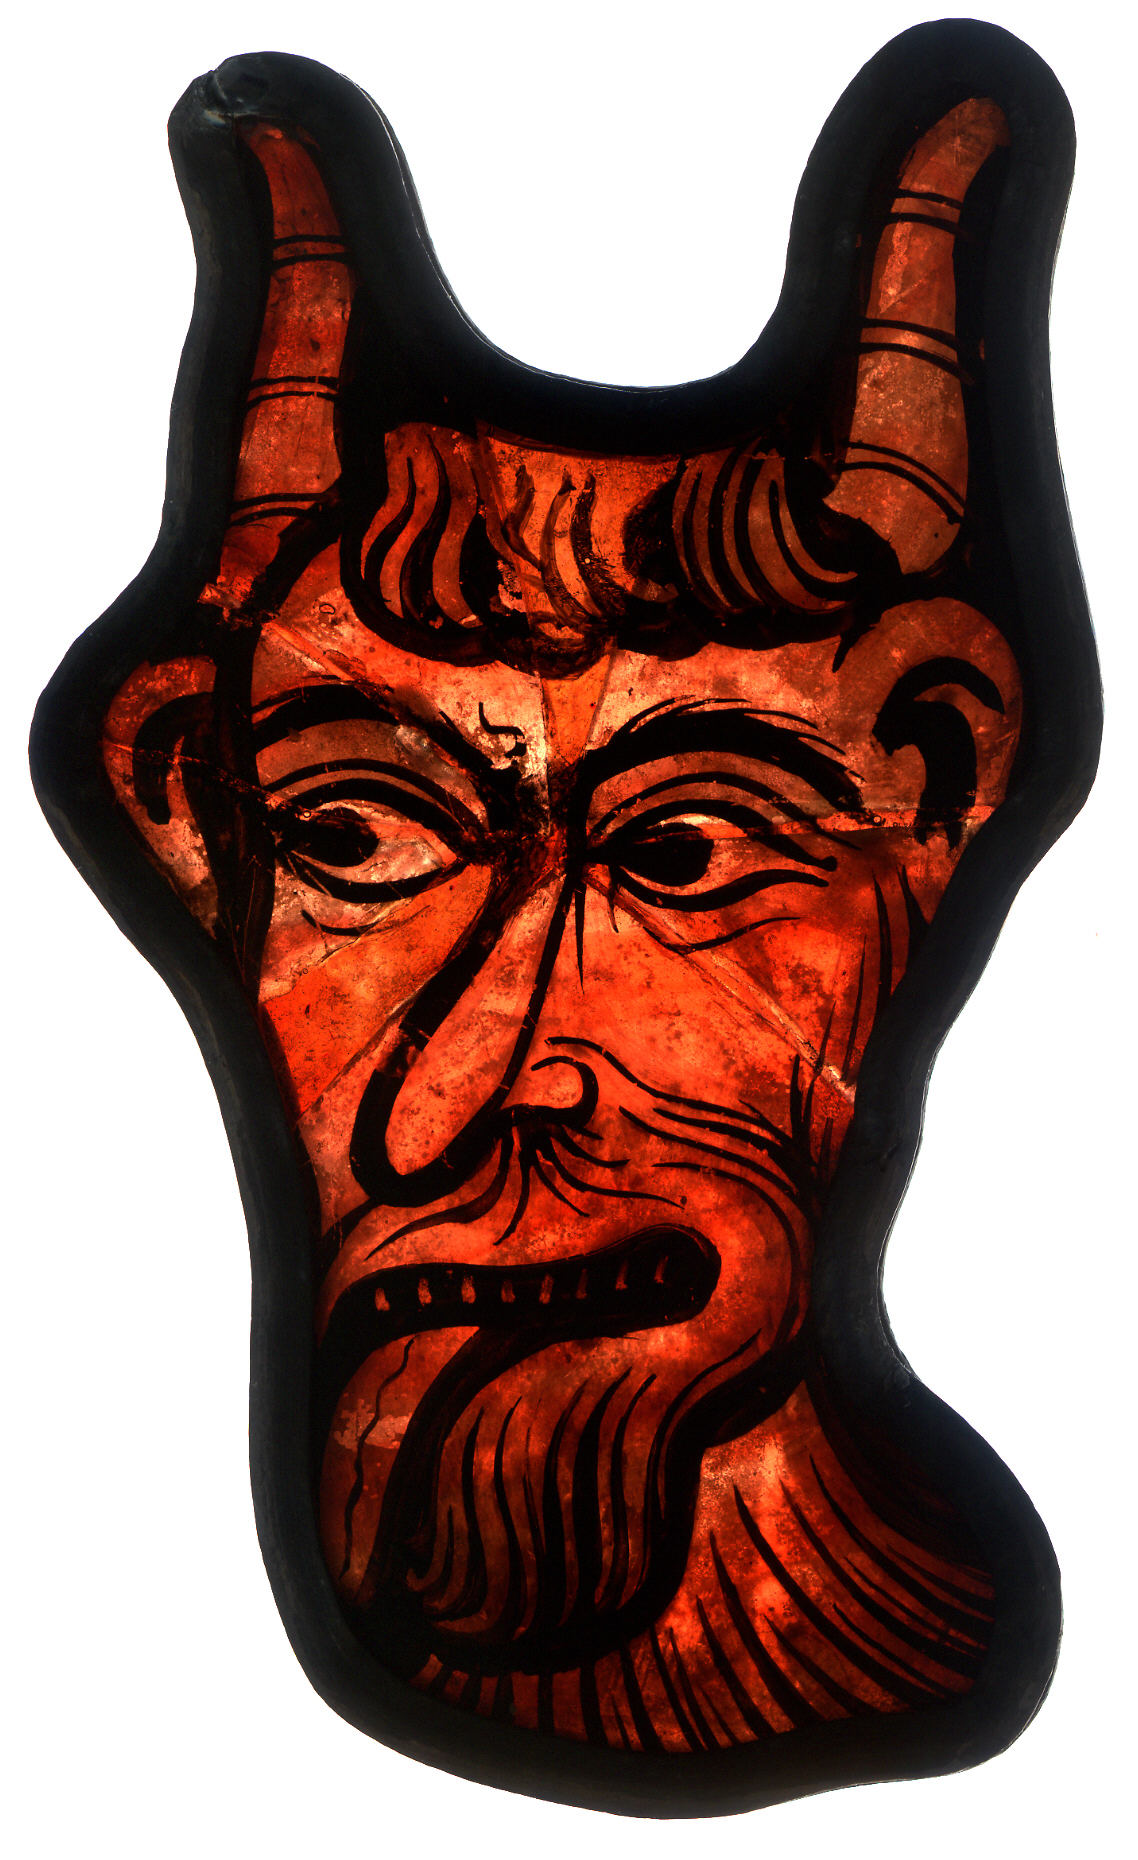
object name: fragment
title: Glass Fragment of a Devil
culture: french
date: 1200-1215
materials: glass, lead, metal, paint